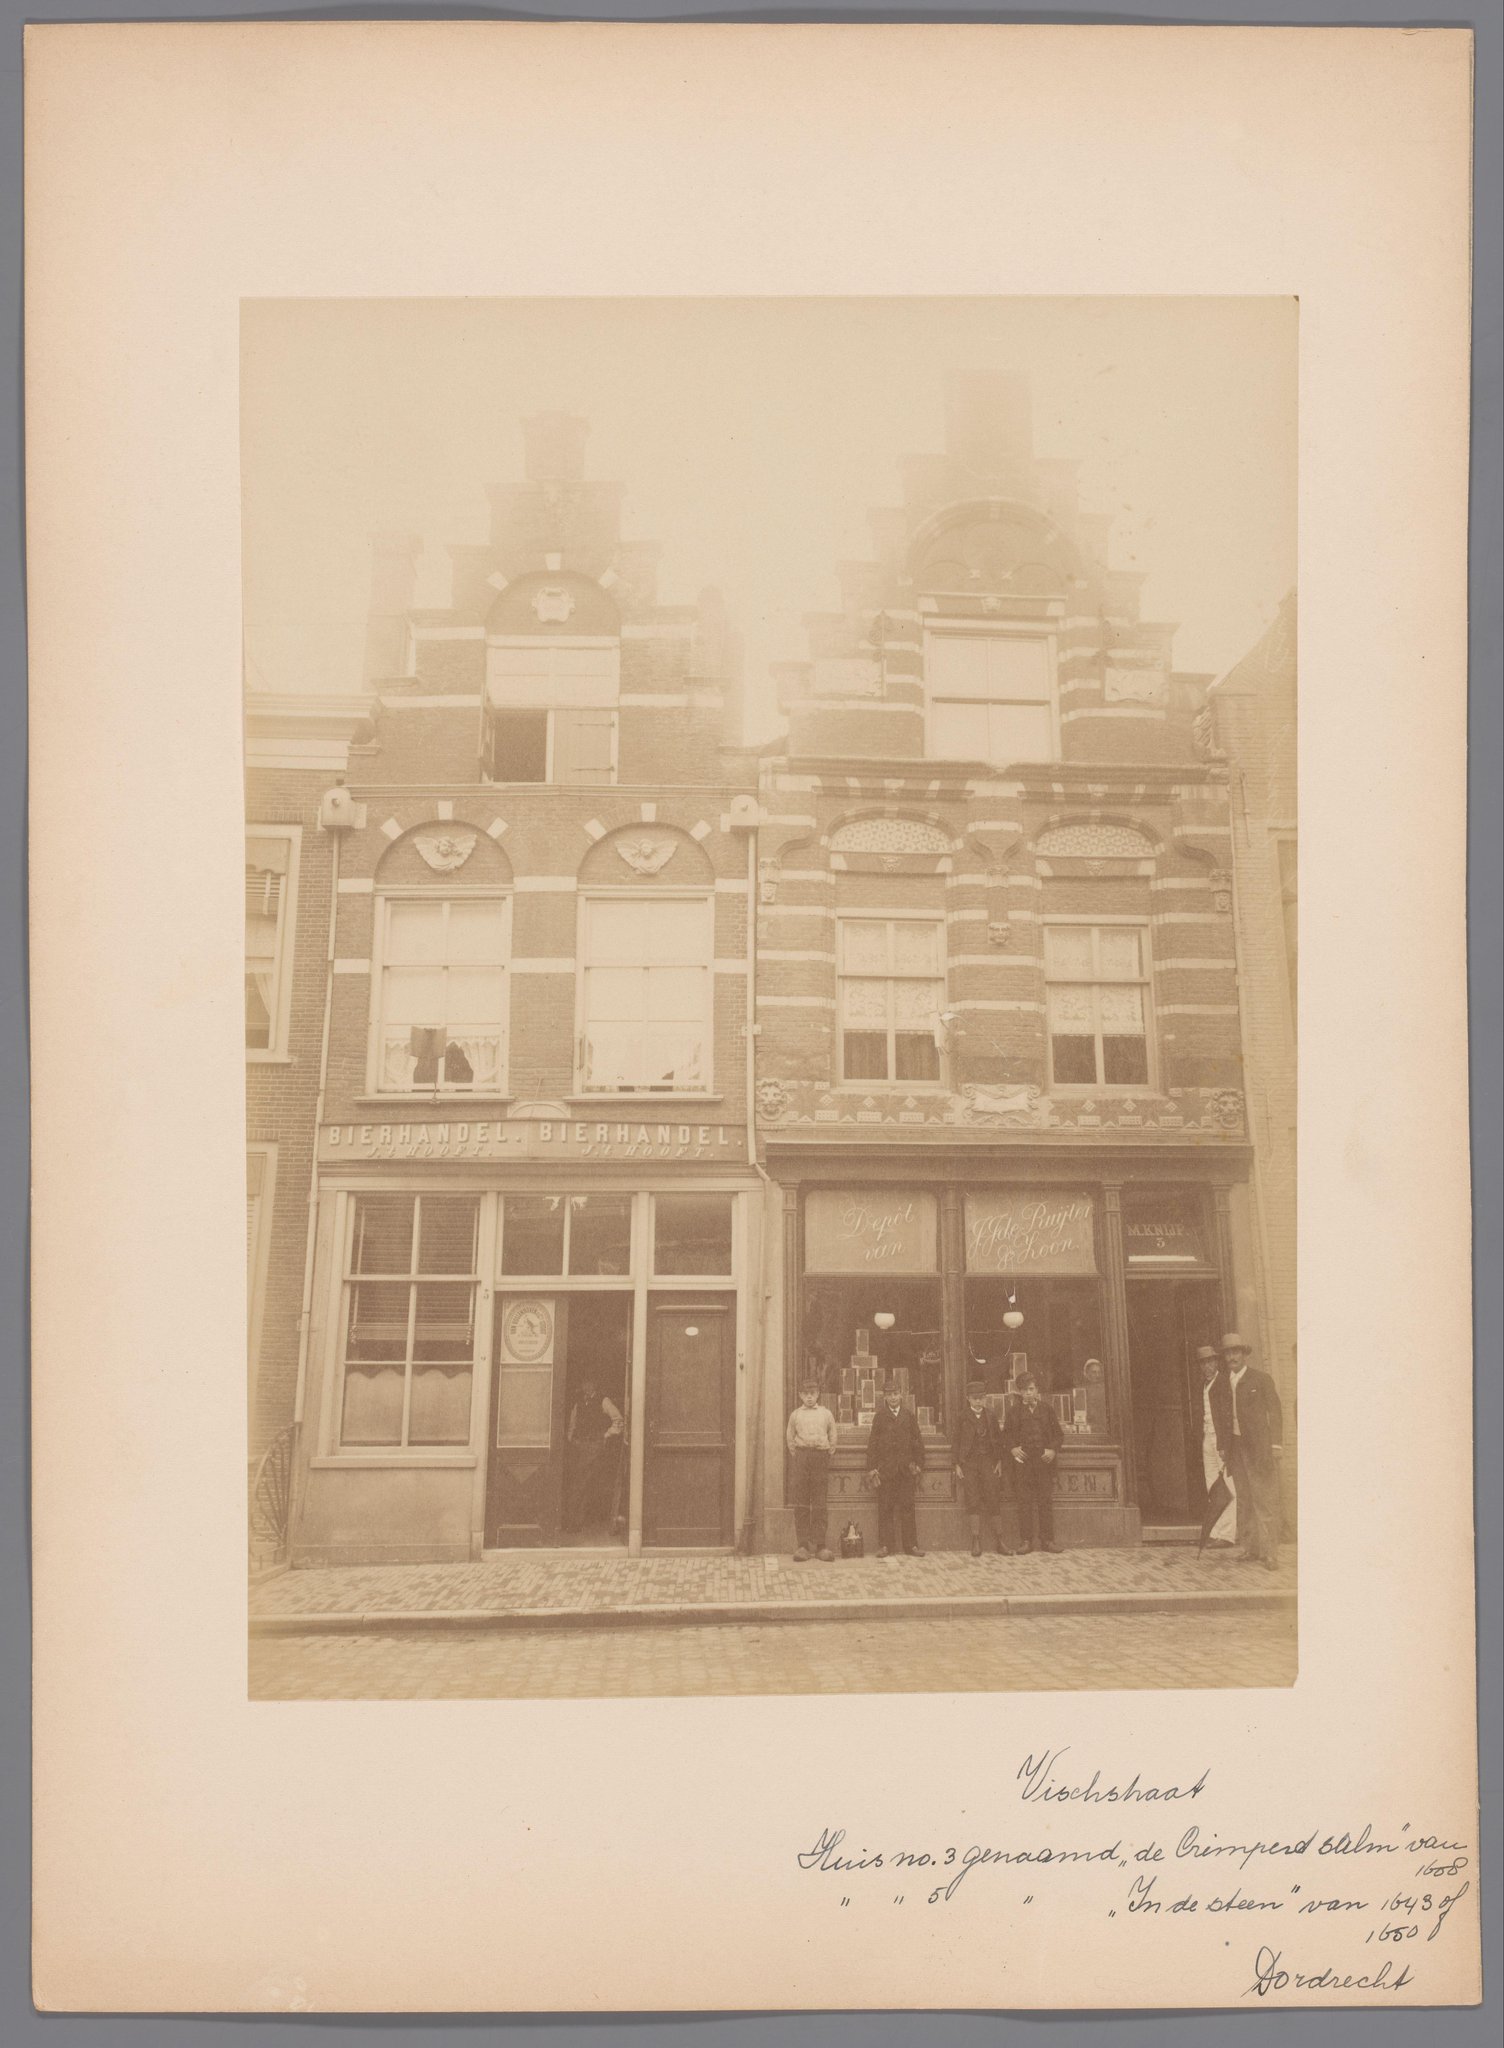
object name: photograph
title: Façades van de Visstraat 3-5 te Dordrecht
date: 1890-1910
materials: cardboard, photographic support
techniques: albumen print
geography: visstraat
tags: shop, store, urban housing, façade (of house or building)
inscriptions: annotation: ‘Dordrecht/ Vischstraat/ Huis no. 3 genaamd "de Crimpert salm"van 1608/ Huis no. 5 genaamd "In de steen" van 1643 of 1650/ Dordrecht’, annotation: ‘Vischstraat/ Huis no. 3 genaamd "de Crimpert salm"van 1608/ Huis no. 5 genaamd "In de steen" van 1643 of 1650/ Dordrecht’